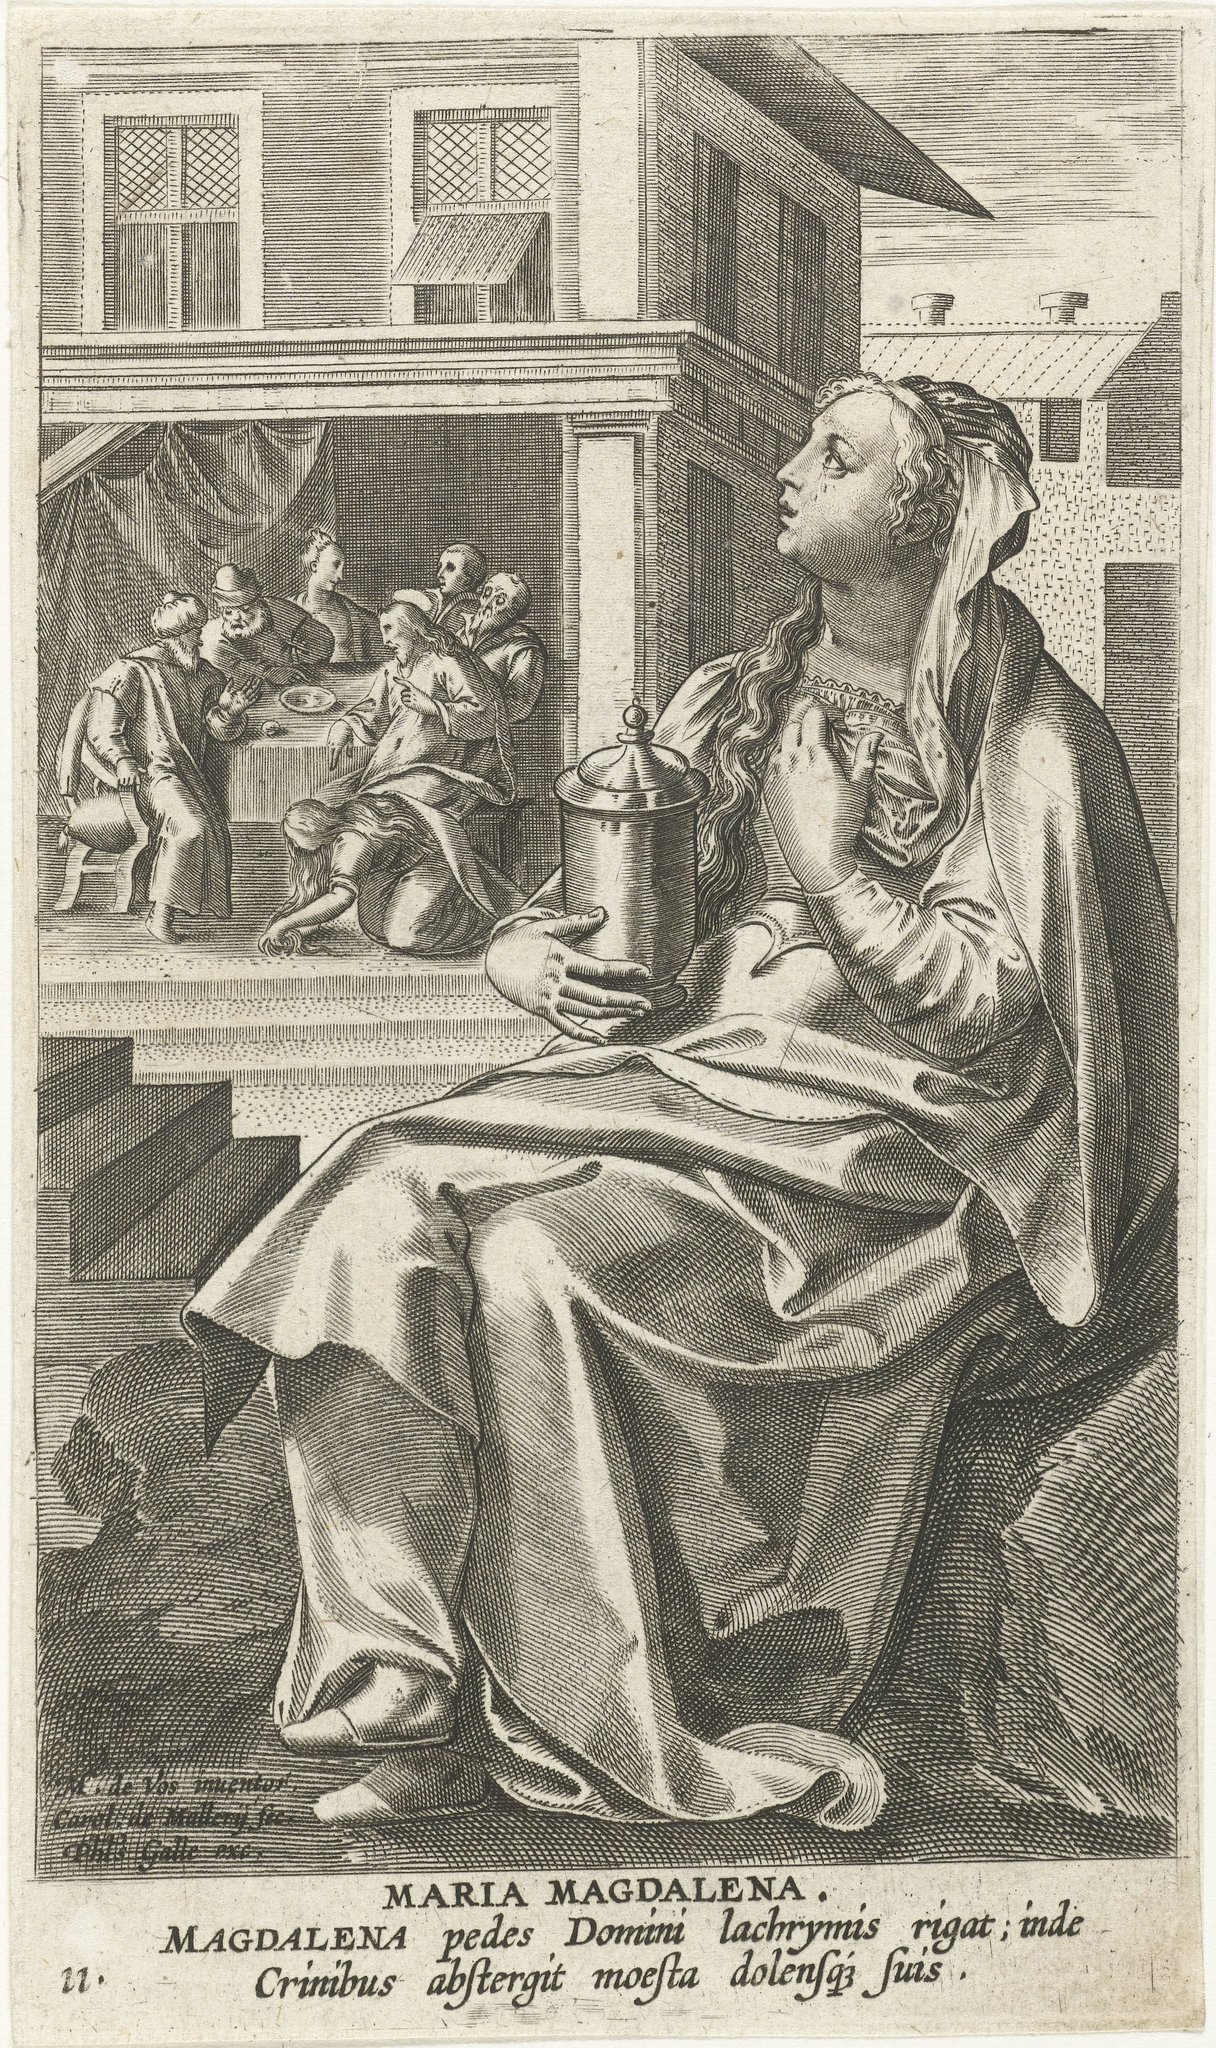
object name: print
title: Icones Illvstrivm Feminarvm Novi Testamenti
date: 1595-1599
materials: paper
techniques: engraving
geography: antwerp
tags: christ's feet are anointed by mary (magdalene), the penitent harlot mary magdalene; possible attributes: book (or scroll), crown, crown of thorns, crucifix, jar of ointment, mirror, musical instrument, palm-branch, rosary, scourge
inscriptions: collector's mark: Lugt 2228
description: Op de voorgrond zit Maria Magdalena, in haar hand een kruik met balsemolie. Op de achtergrond zalft Maria Magdalena de voeten van Christus als hij te gast is bij Simon de Farizeeër. De prent heeft een Latijns onderschrift en maakt deel uit van een prentserie met beroemde vrouwen uit het Nieuwe Testament